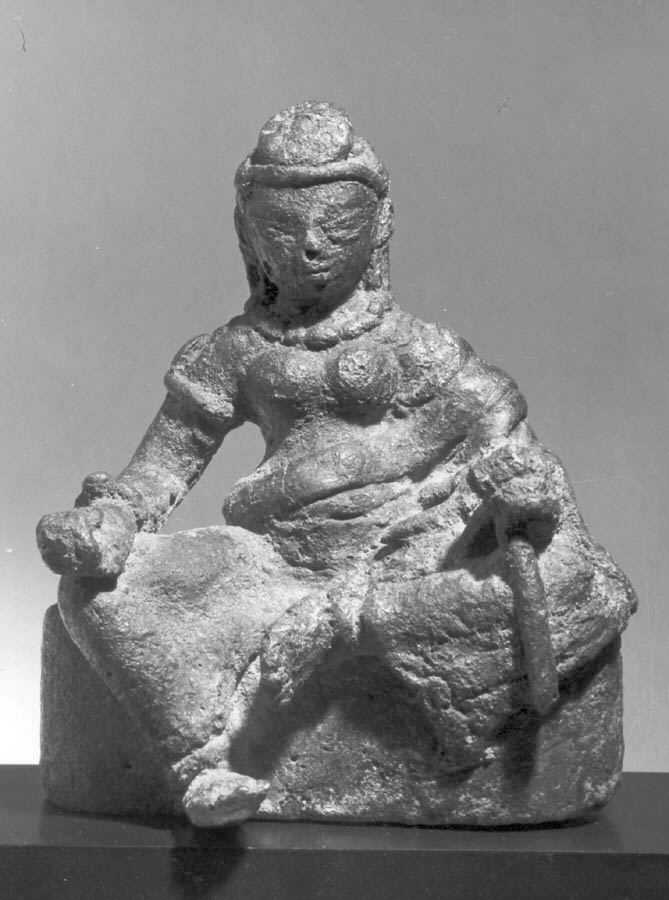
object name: figurine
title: Seated Goddess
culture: indian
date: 101-300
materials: bronze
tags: kushan,mathura,goddess